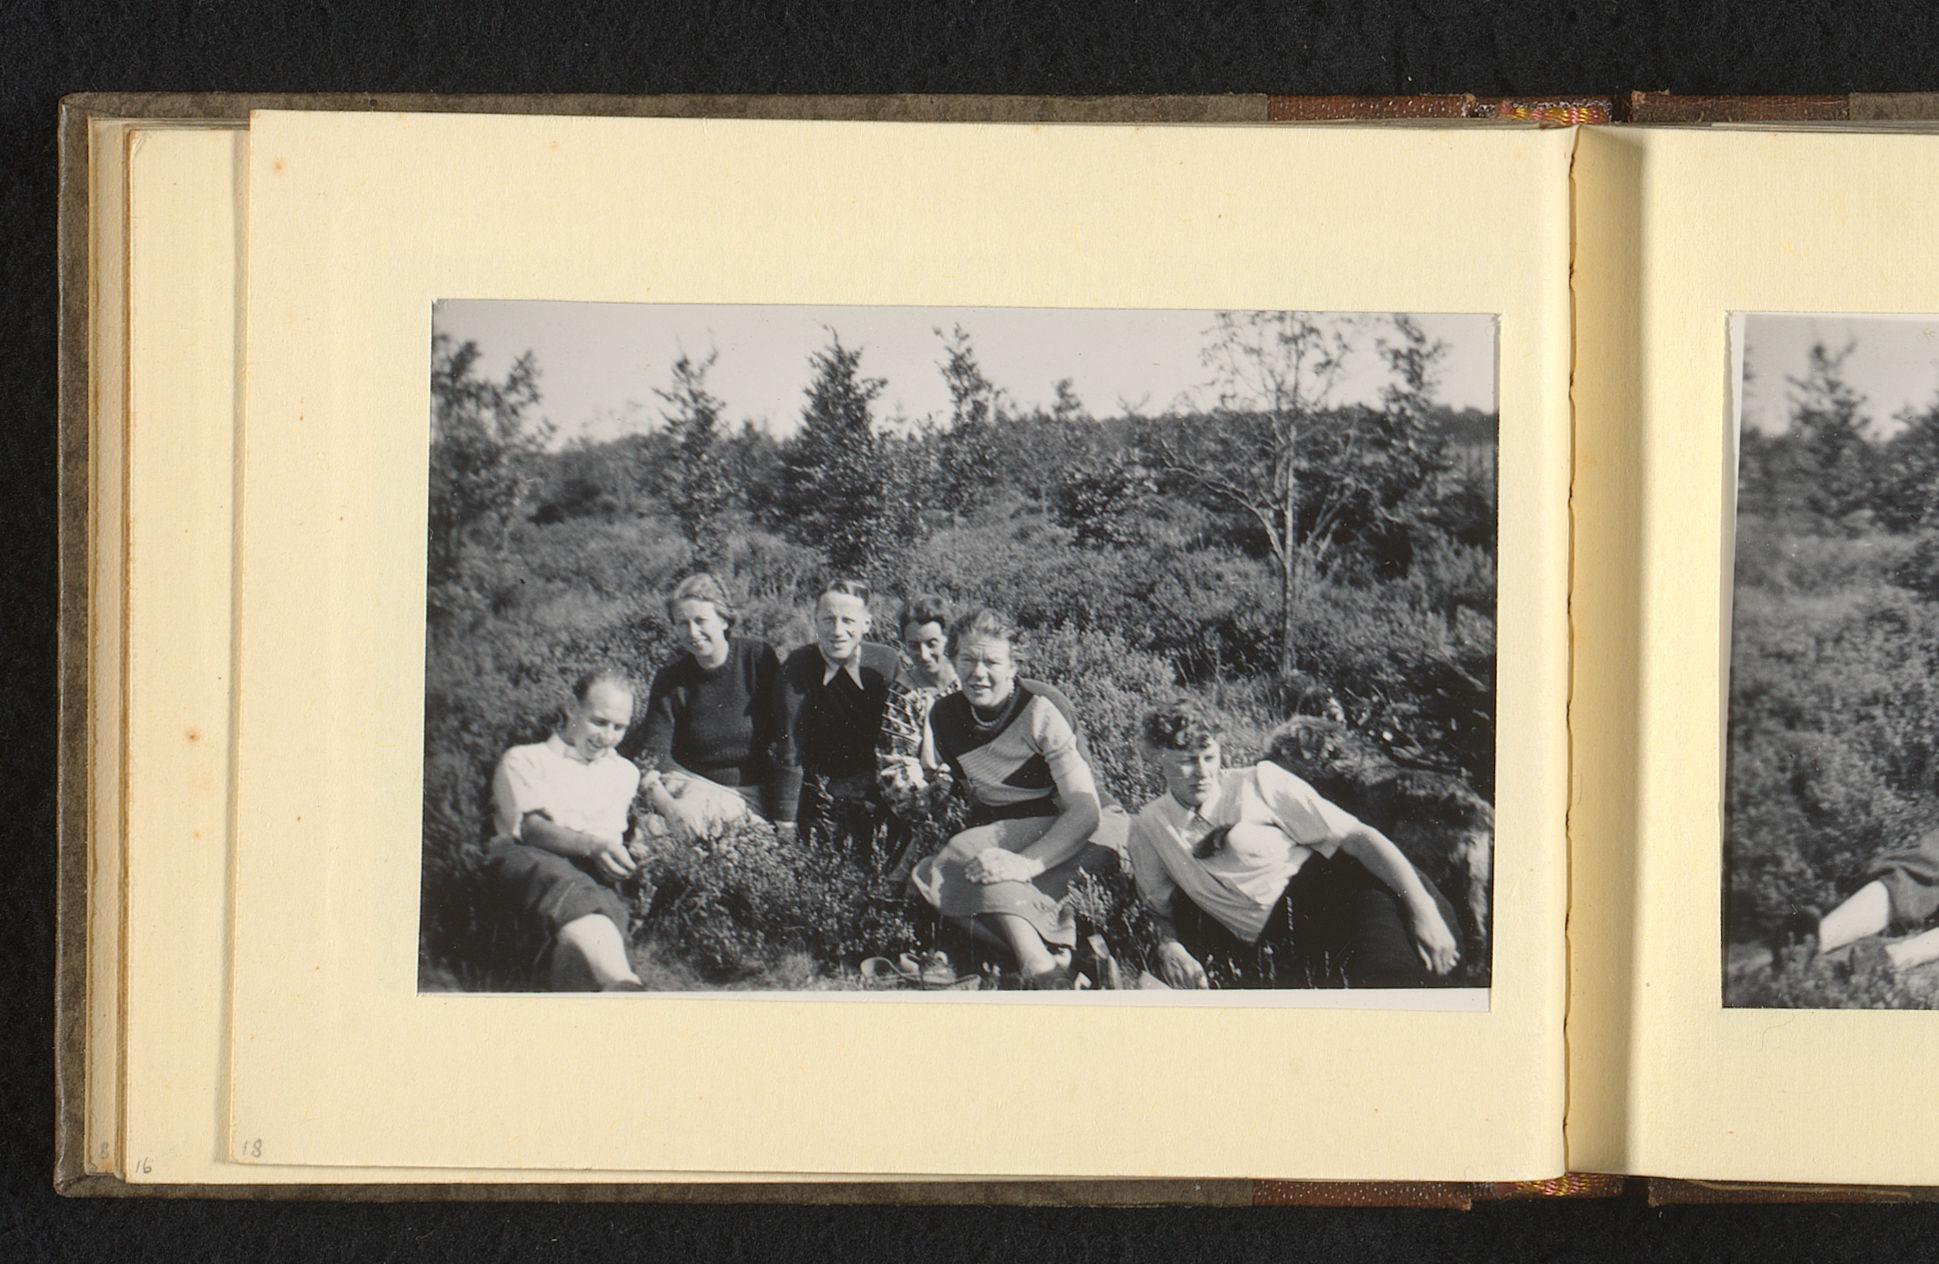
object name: album leaf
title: Vier vrouwen en twee mannen zittend in struikgewas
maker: norbert van den berg (1901-1972)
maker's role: amateurfotograaf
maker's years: 1901-1972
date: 1935-1950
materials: paper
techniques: gelatin silver print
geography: netherlands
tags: adult woman, shrubs, adult man